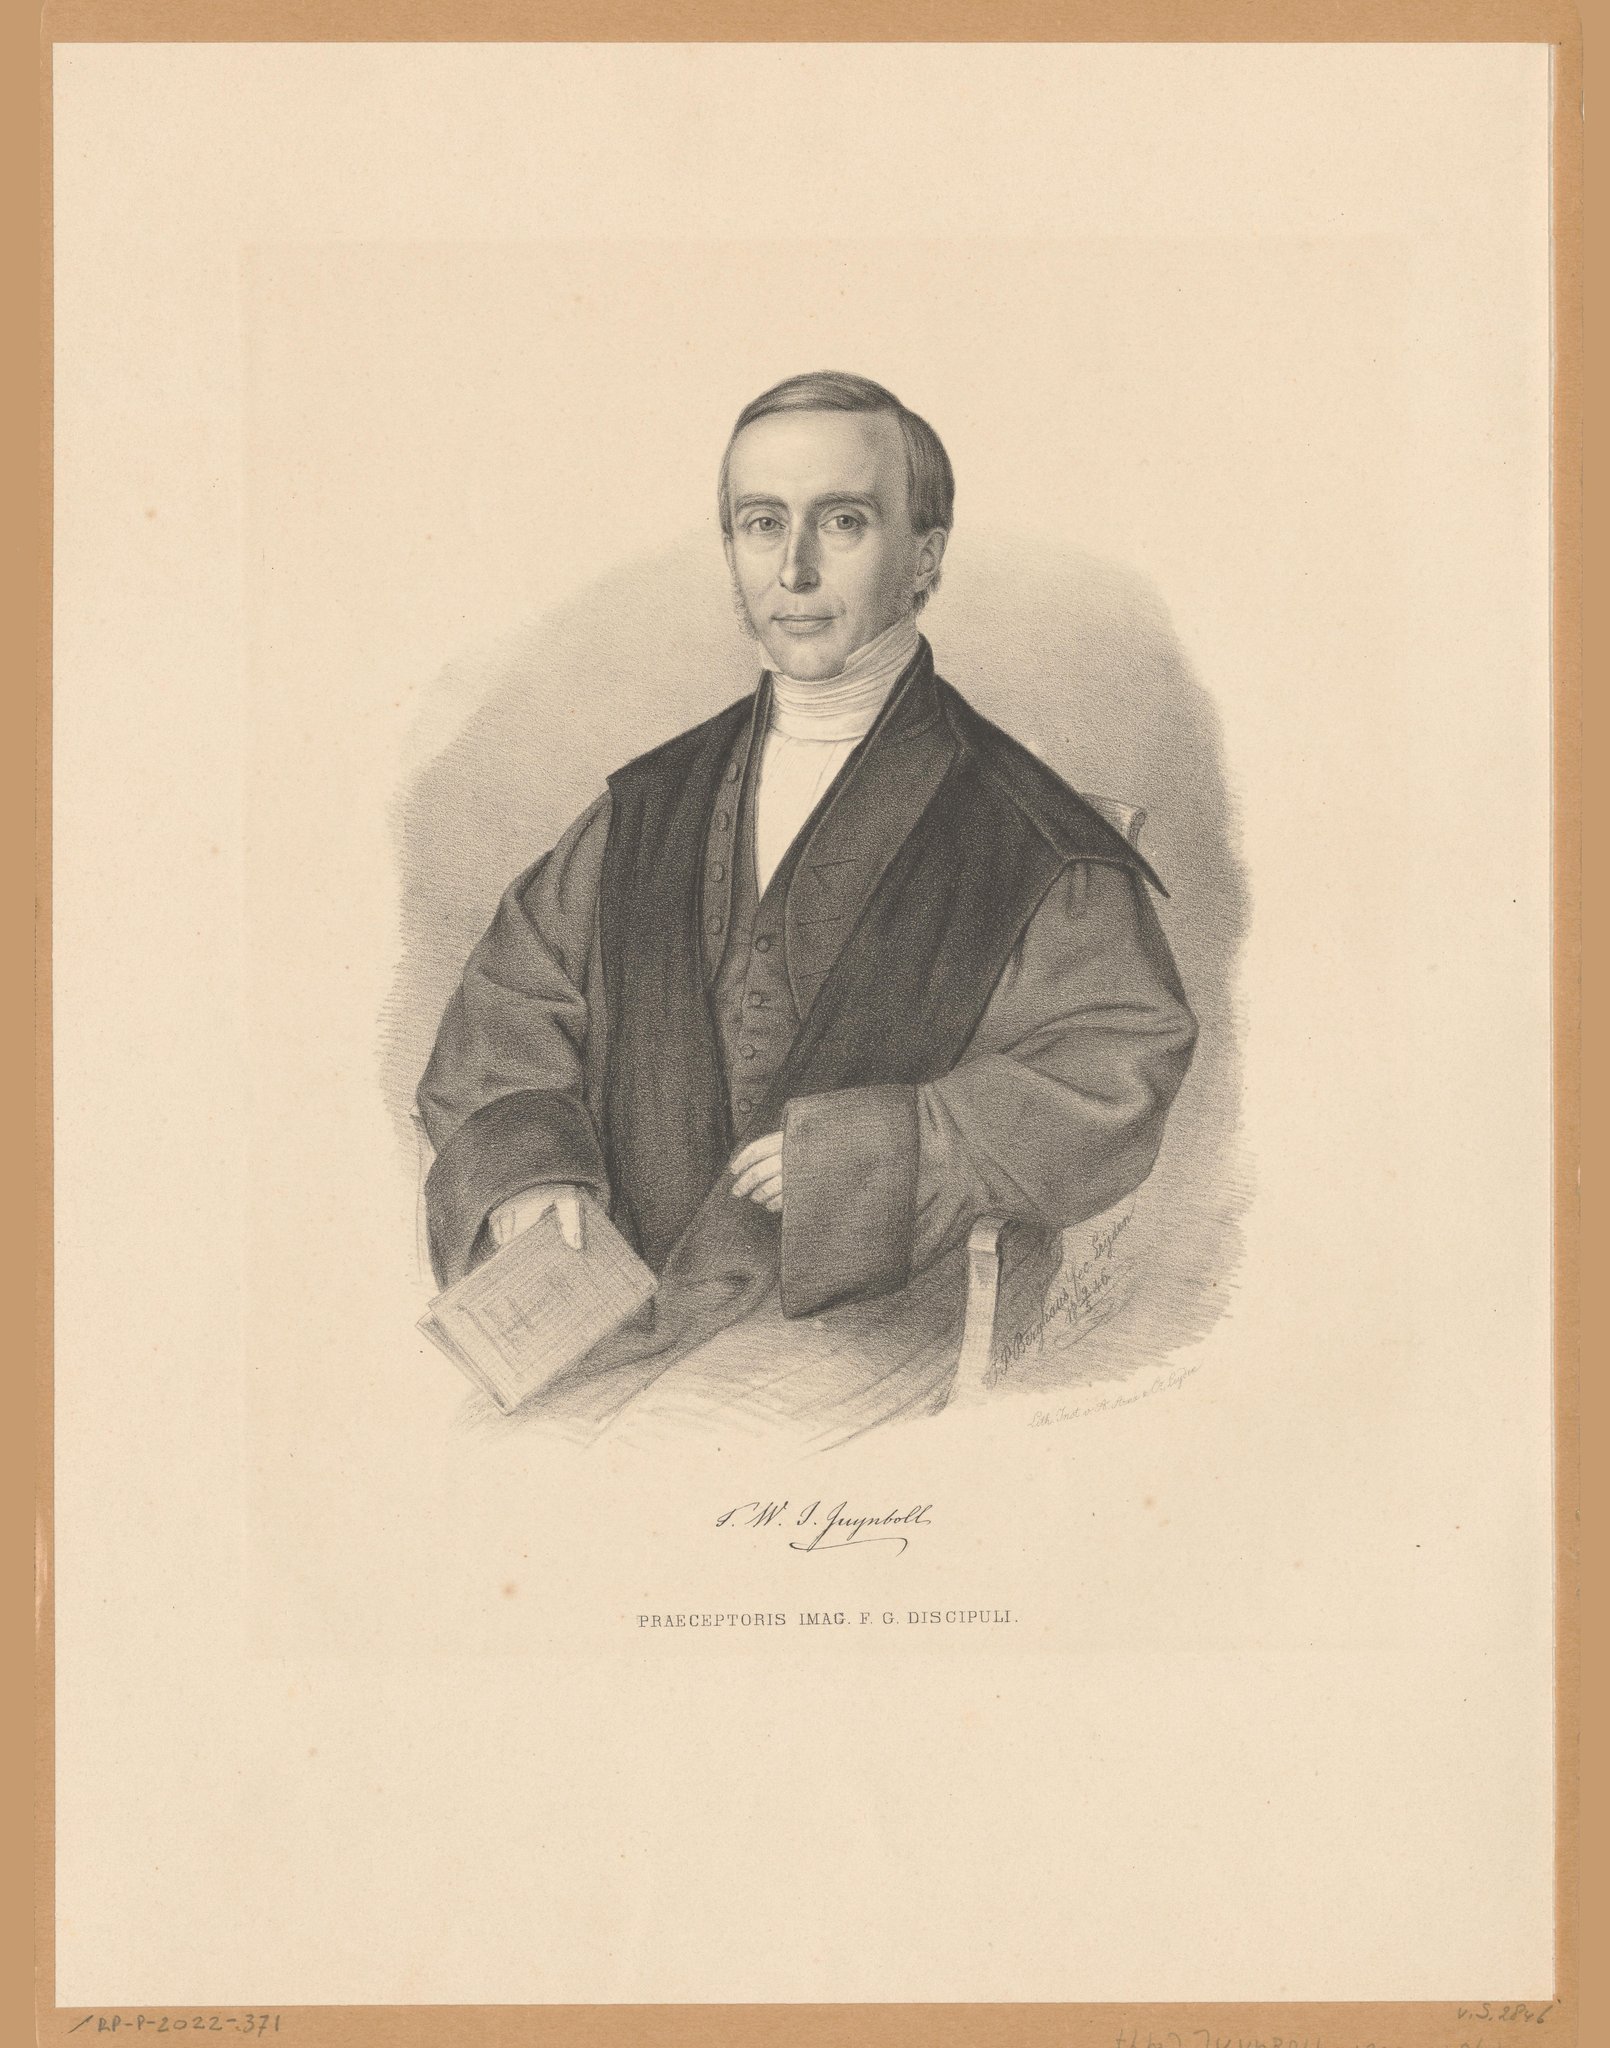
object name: print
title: Portret van Theodoor Willem Johannes Juynboll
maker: johann peter berghaus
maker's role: print maker, printer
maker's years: 1810-1870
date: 1846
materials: paper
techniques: lithograph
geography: leiden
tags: rotterdam, leiden, historical persons, professor